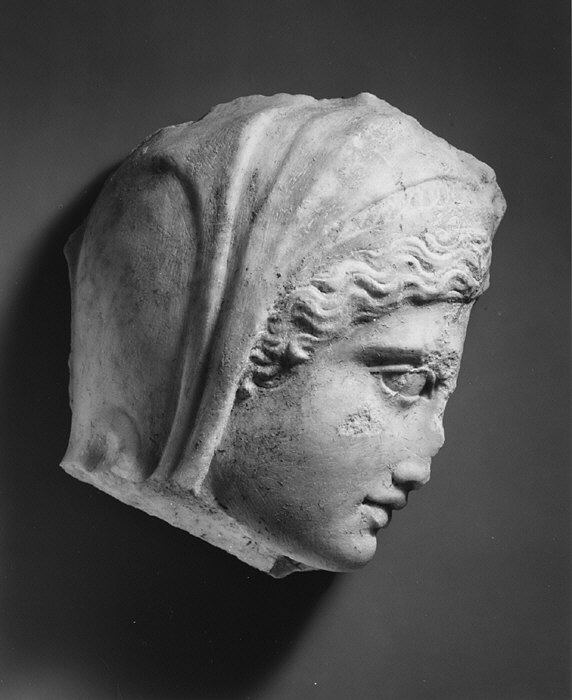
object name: relief fragment with head of medea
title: Marble relief fragment with the head of Medea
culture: roman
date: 1-200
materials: marble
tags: heads,medea